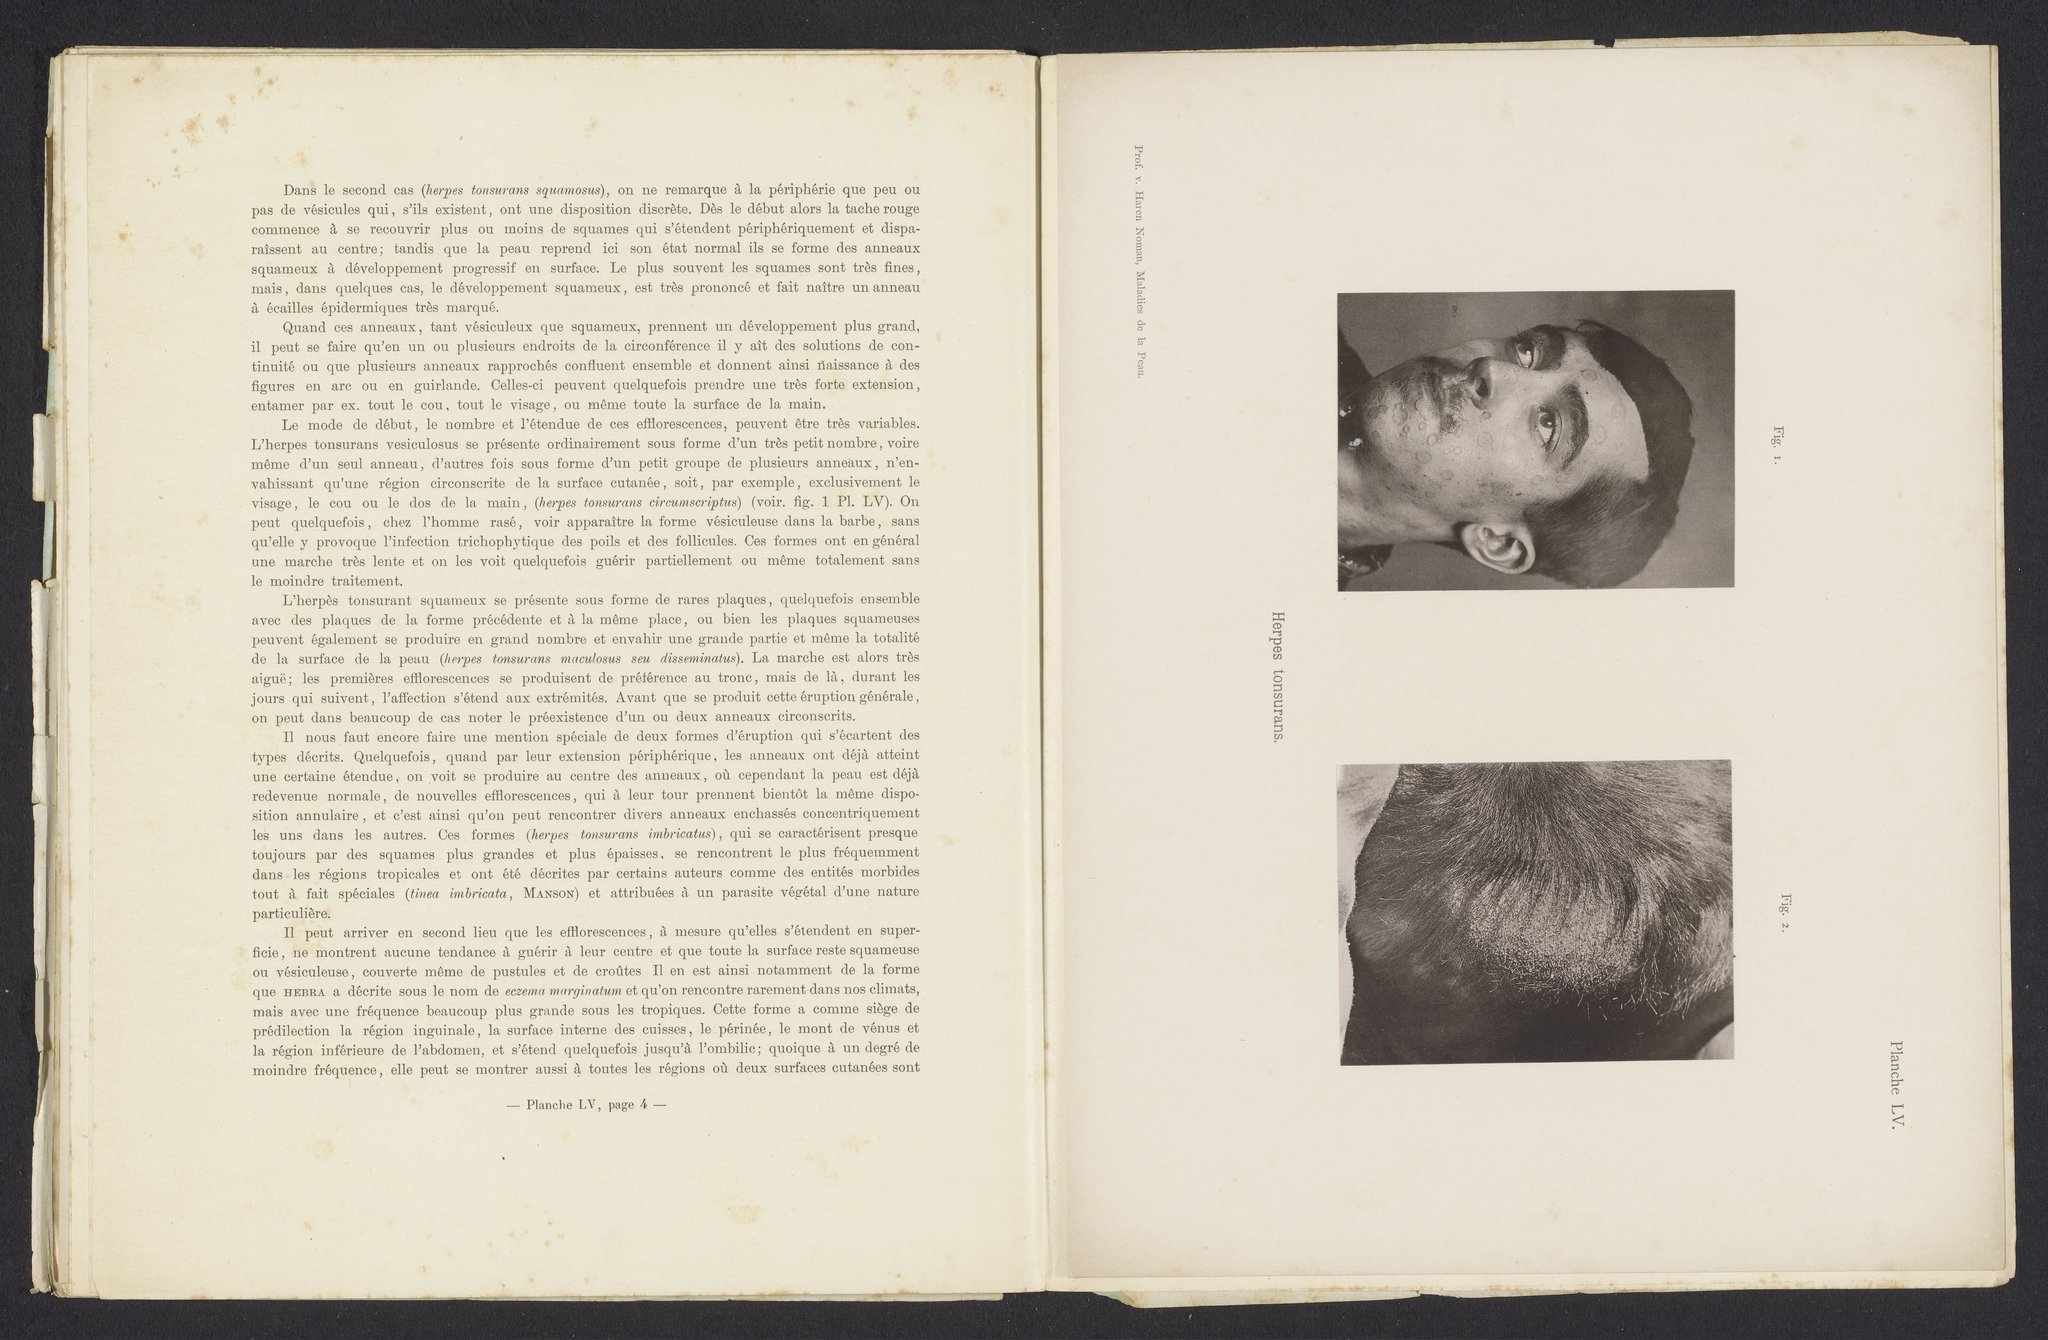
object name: photomechanical print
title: Herpes tonsurans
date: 1885-1895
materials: paper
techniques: photograph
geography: haarlem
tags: face, skin and venereal diseases, adult man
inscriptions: number: ‘Planche LV. / Fig. 1. / Fig. 2’